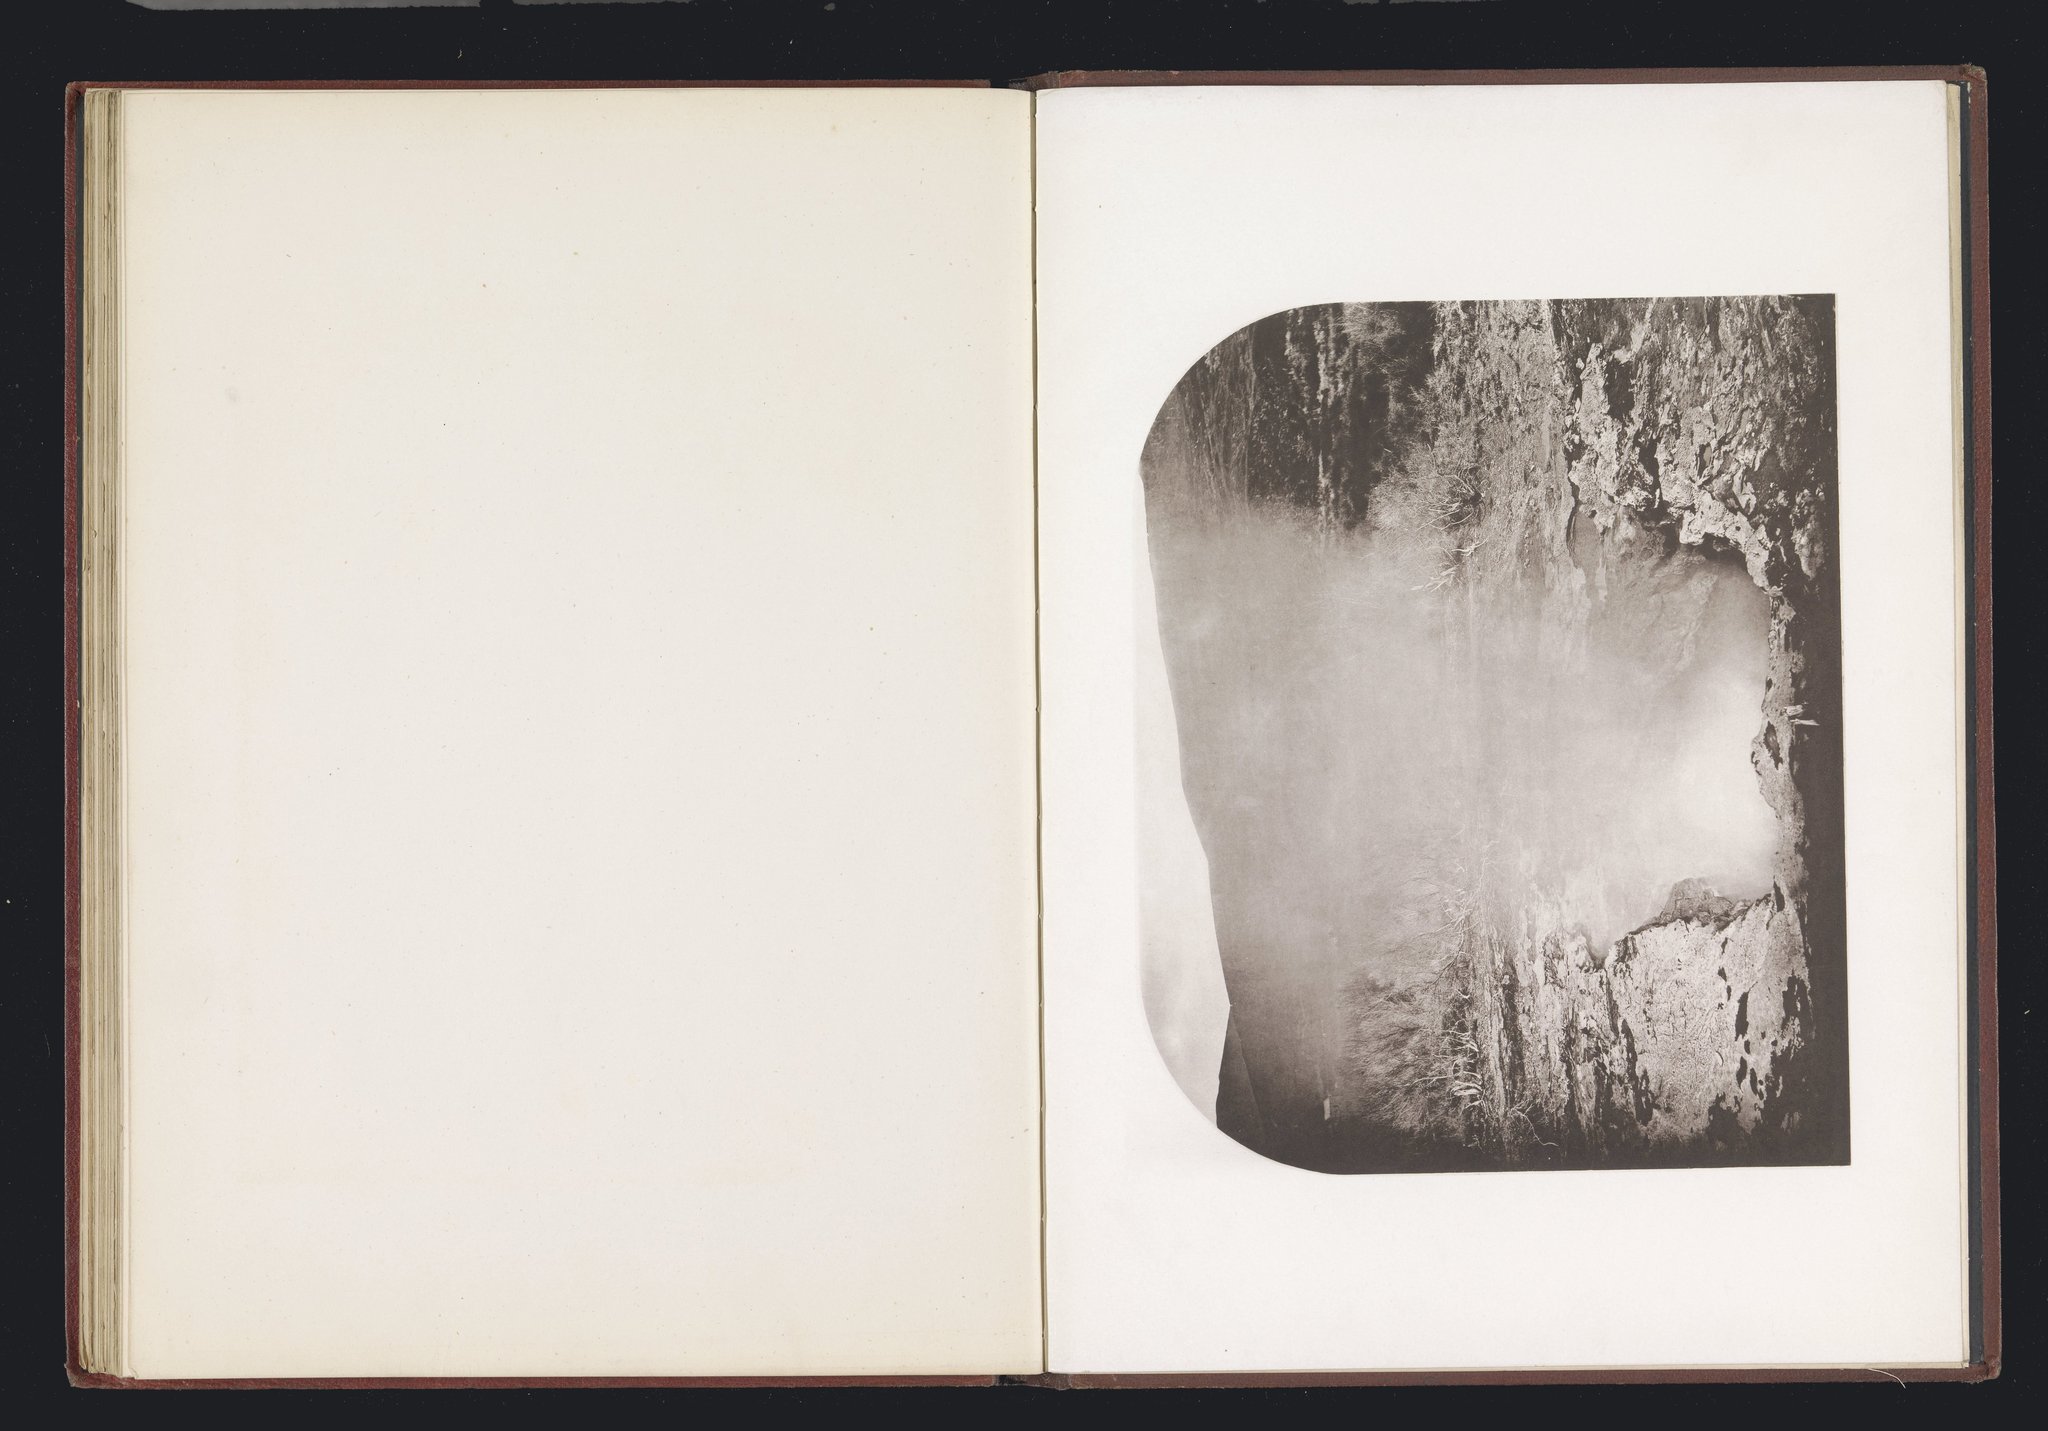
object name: page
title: Pirori-geiser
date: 1865-1875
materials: paper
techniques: photograph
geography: new zealand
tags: hot spring, geyser